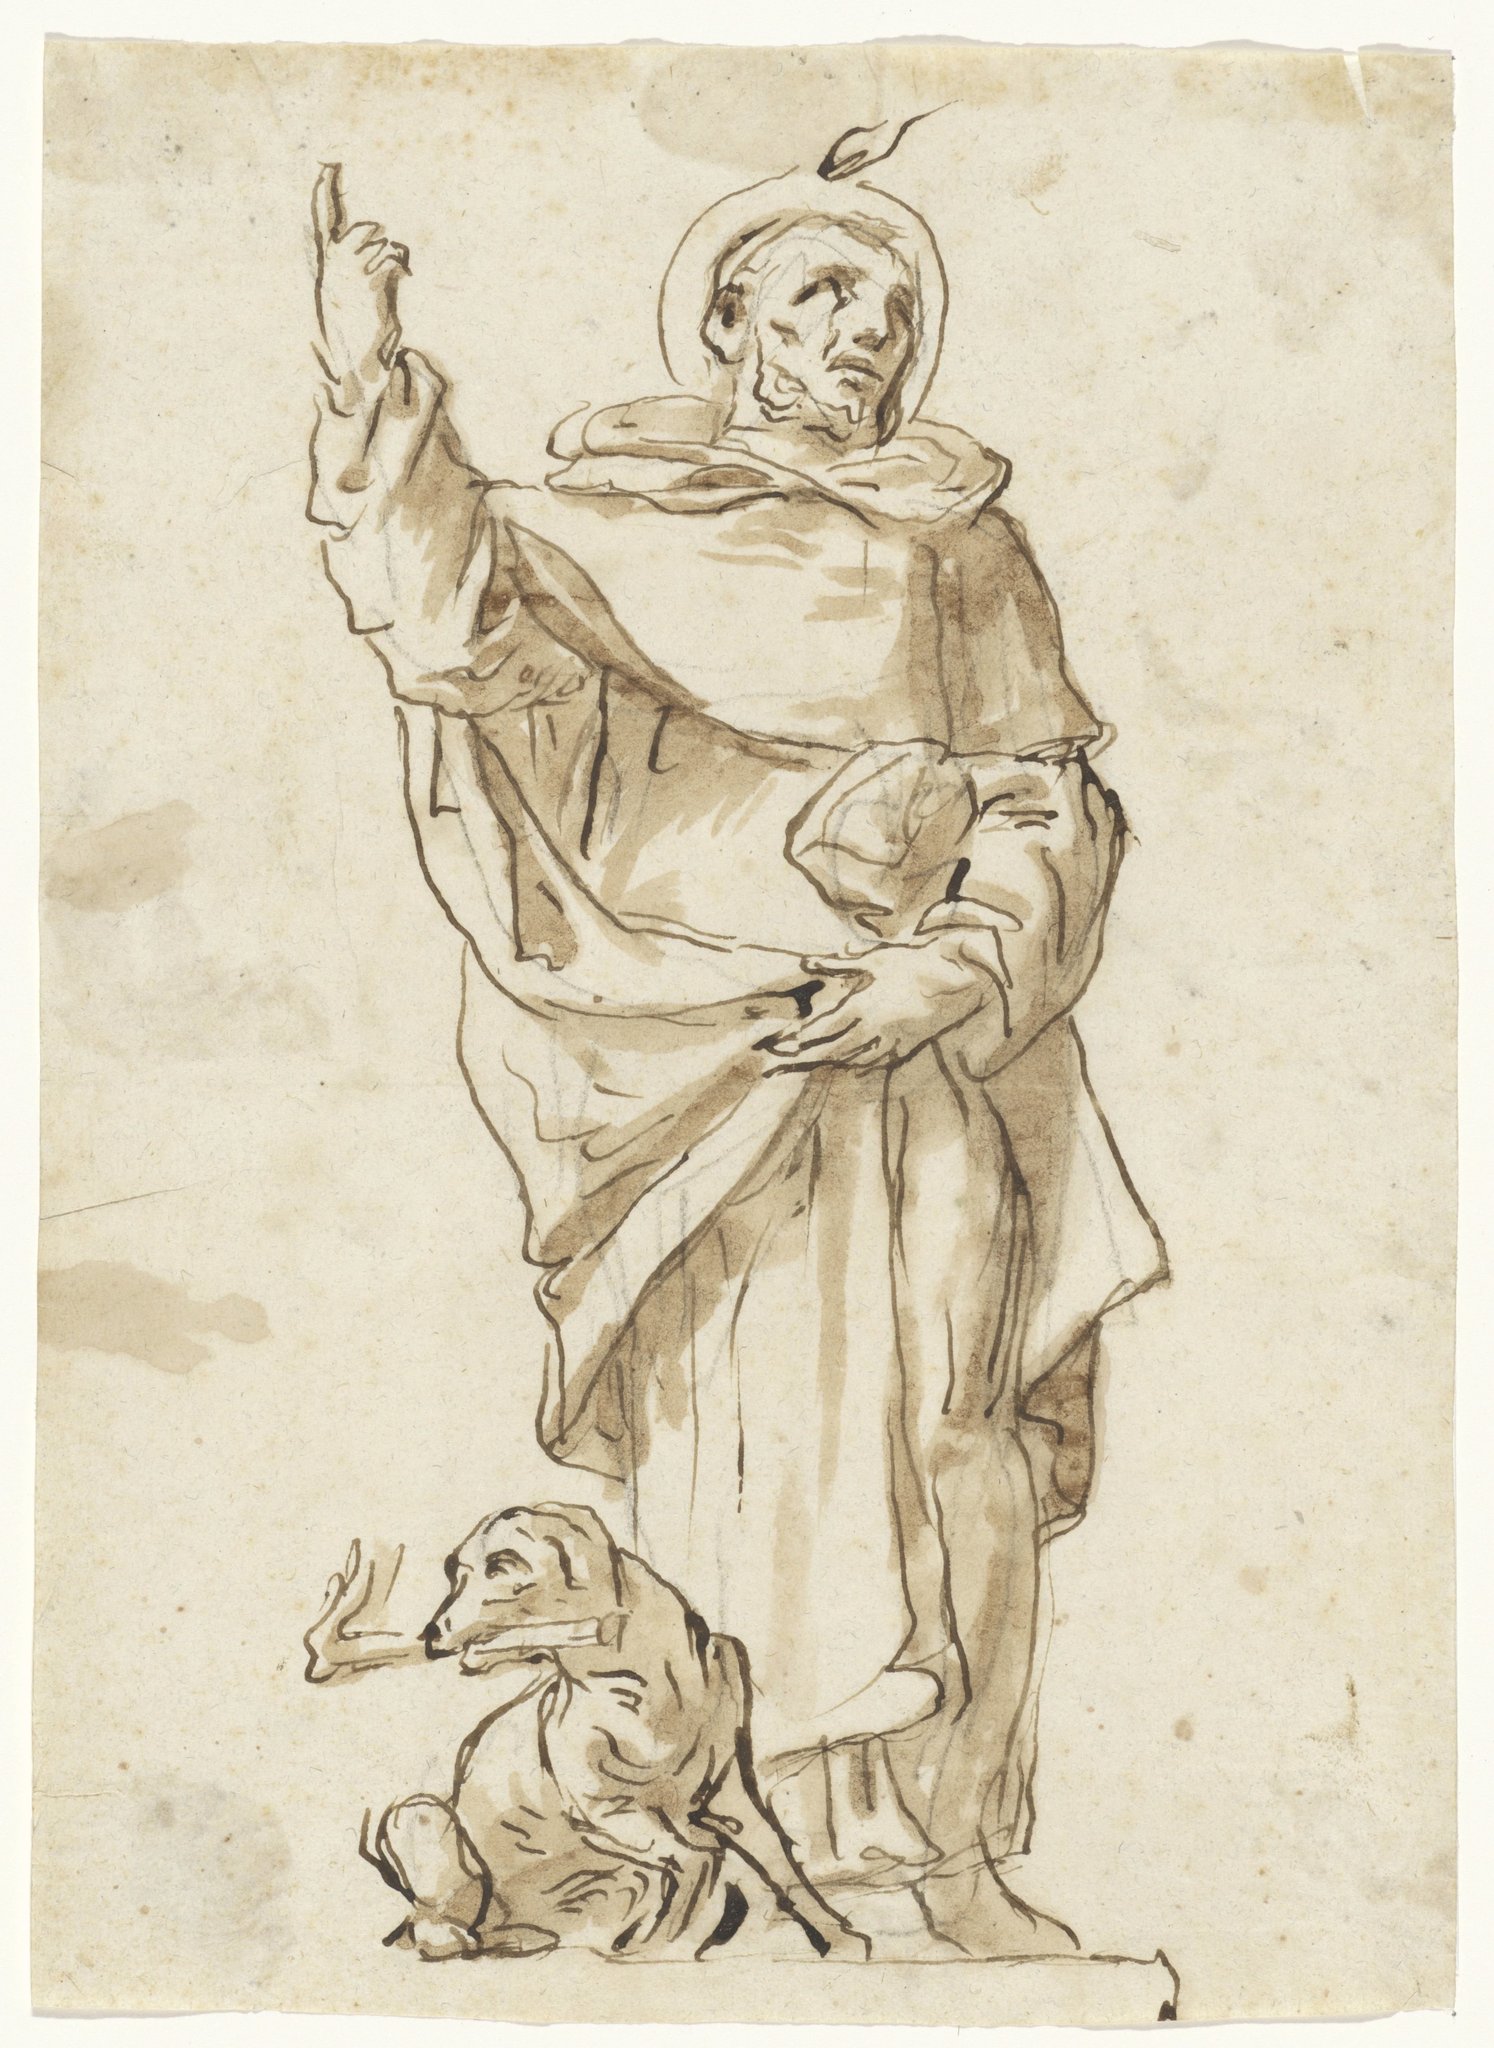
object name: drawing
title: H. Dominicus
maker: Anonymous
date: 1700-1799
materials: ink, paper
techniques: brush, pen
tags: dominic(us) guzman of calerueja, founder of the order of preachers (or dominican (black) friars; possible attributes: book, dog with flaming torch, lily, loaf of bread, rosary, star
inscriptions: collector's mark:, collector's mark: Lugt 2228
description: De heilige Dominicus staat en wijst omhoog. Een hond met een brandende fakkel in de bek ligt aan zijn voeten.